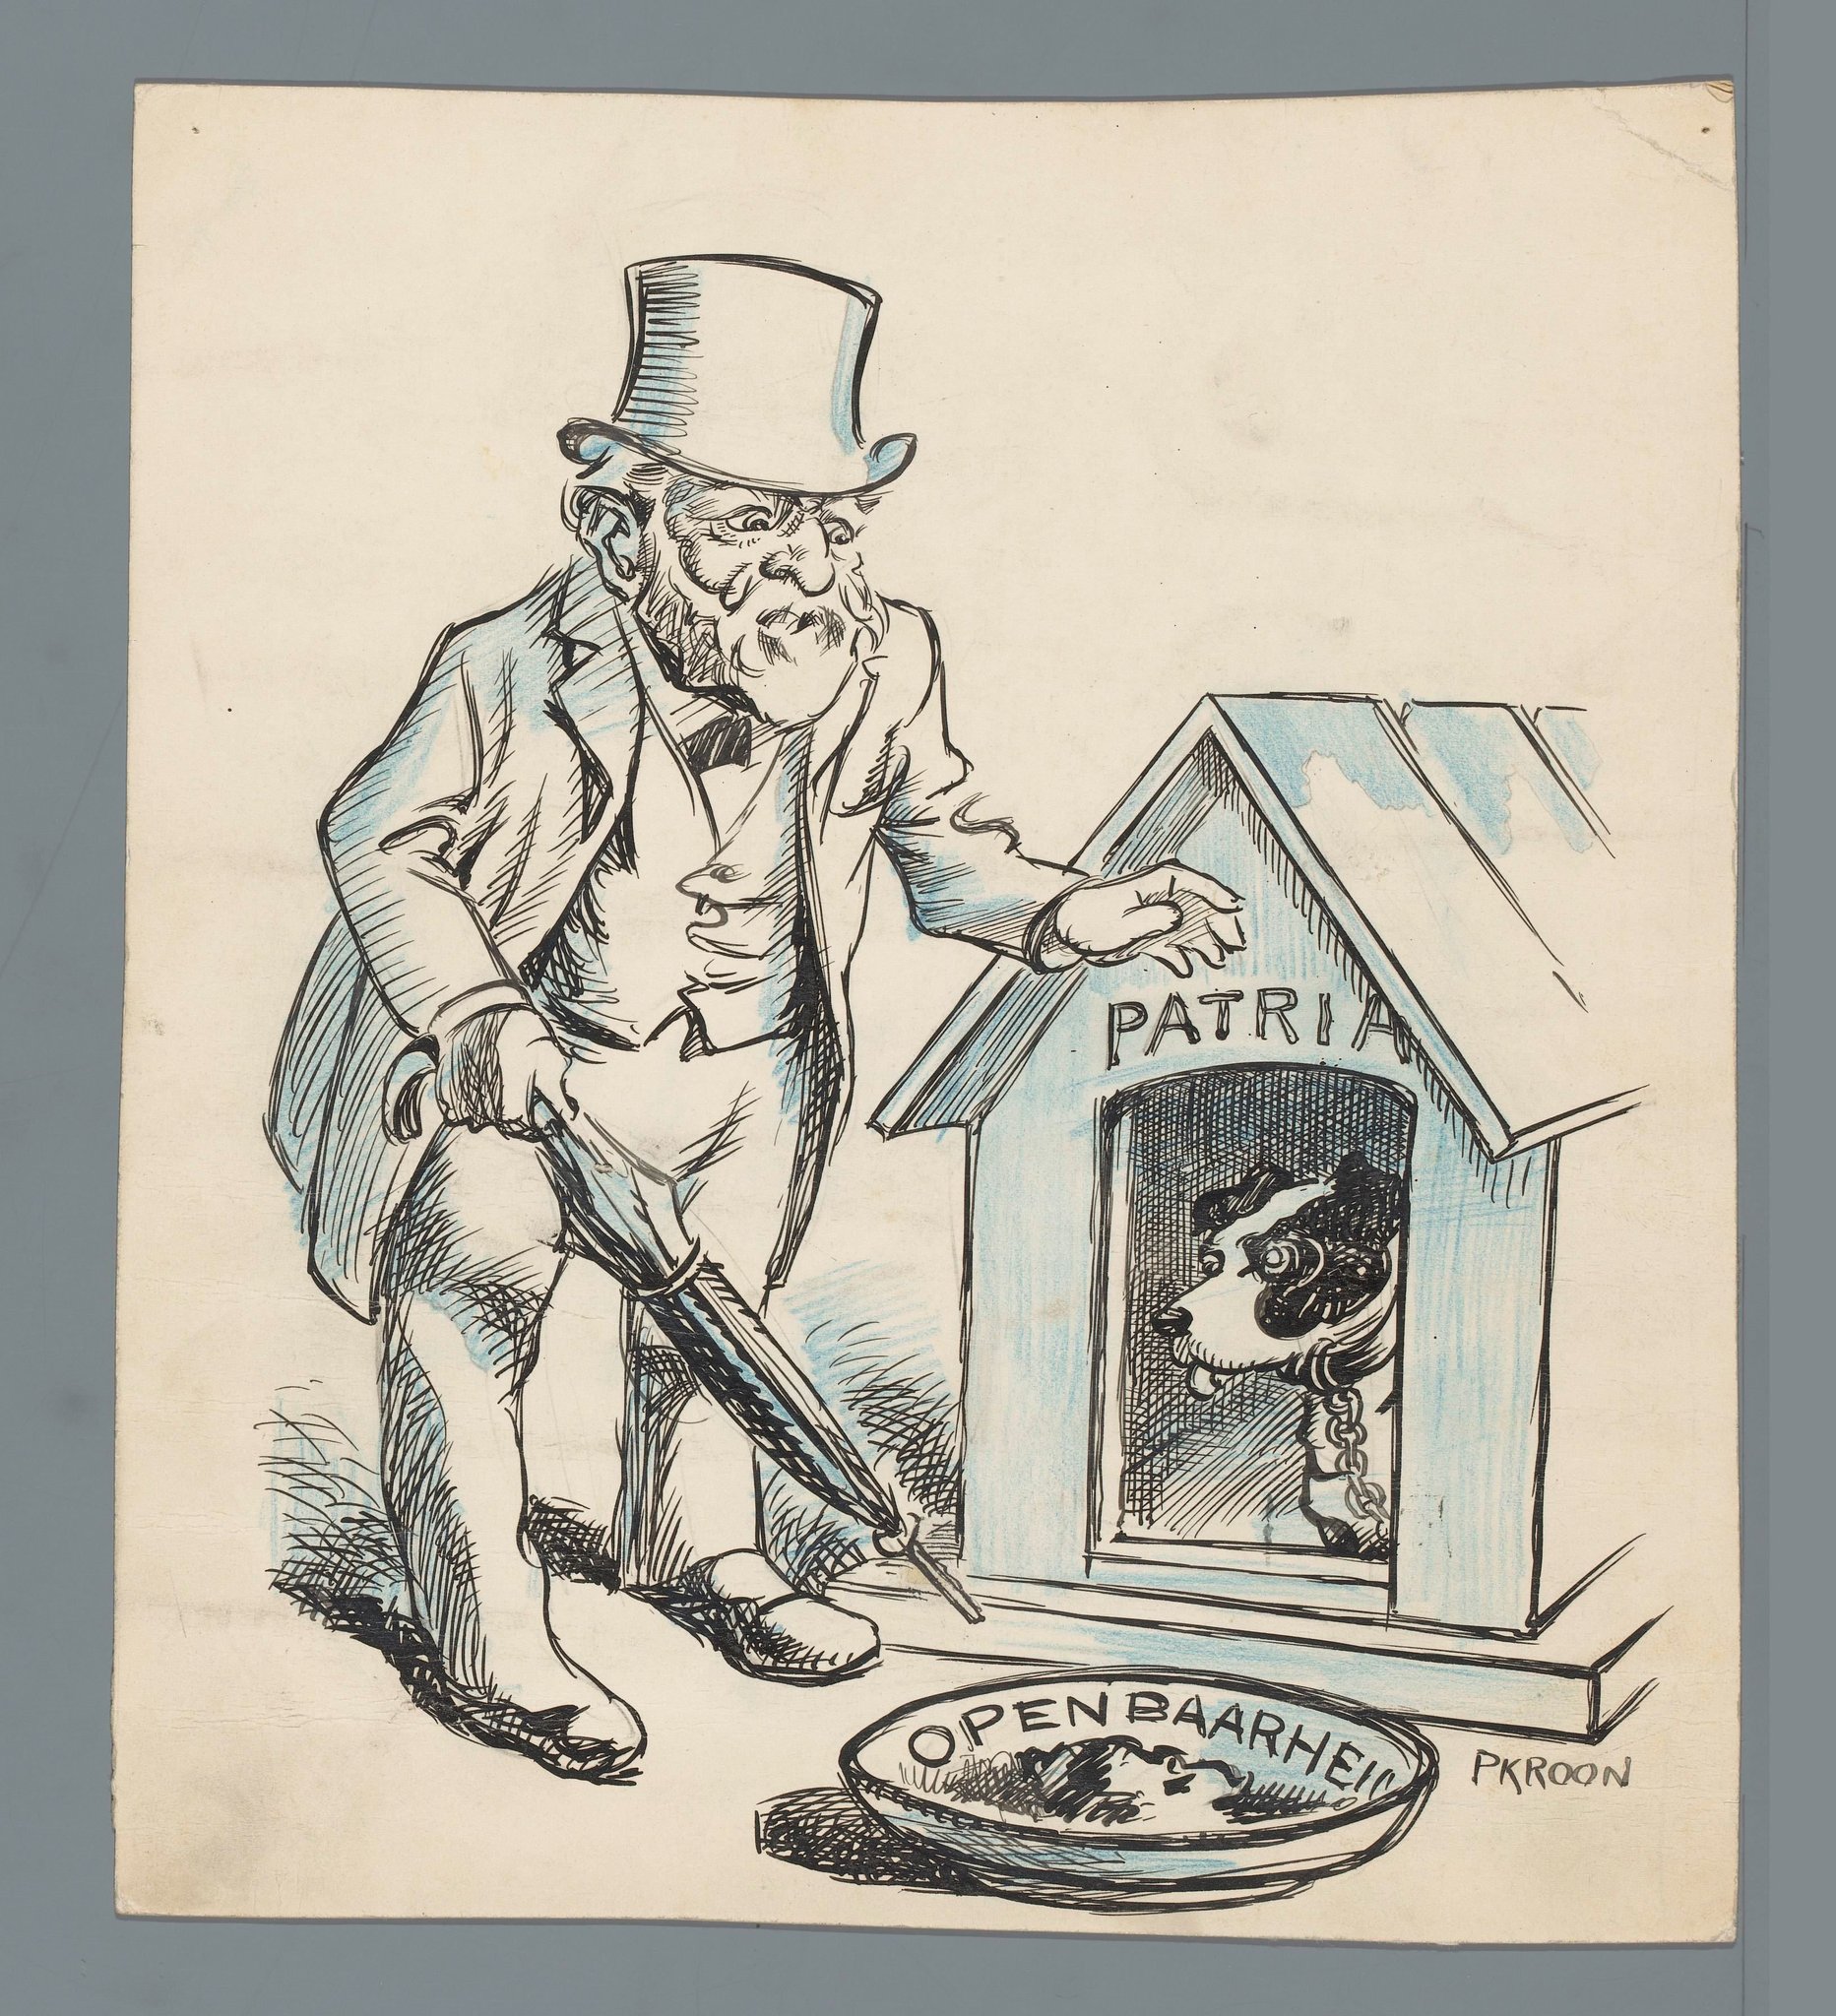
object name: drawing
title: Minister Cort en de openbaarheid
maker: patricq kroon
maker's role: draughtsman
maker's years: 1862-1941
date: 1920-1930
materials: ink, paper, pencil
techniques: pen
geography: netherlands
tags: politician, political caricatures and satires, dog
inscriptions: stamp: ‘N.V. Uitgevers Mm. / "Amsterdam" / De Directie’, inscription: ‘Minister Cort en de openbaarheid’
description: Minister Cort van der Linden geeft een hond (Patria) te weinig te eten. Ontwerp voor een politieke spotprent.